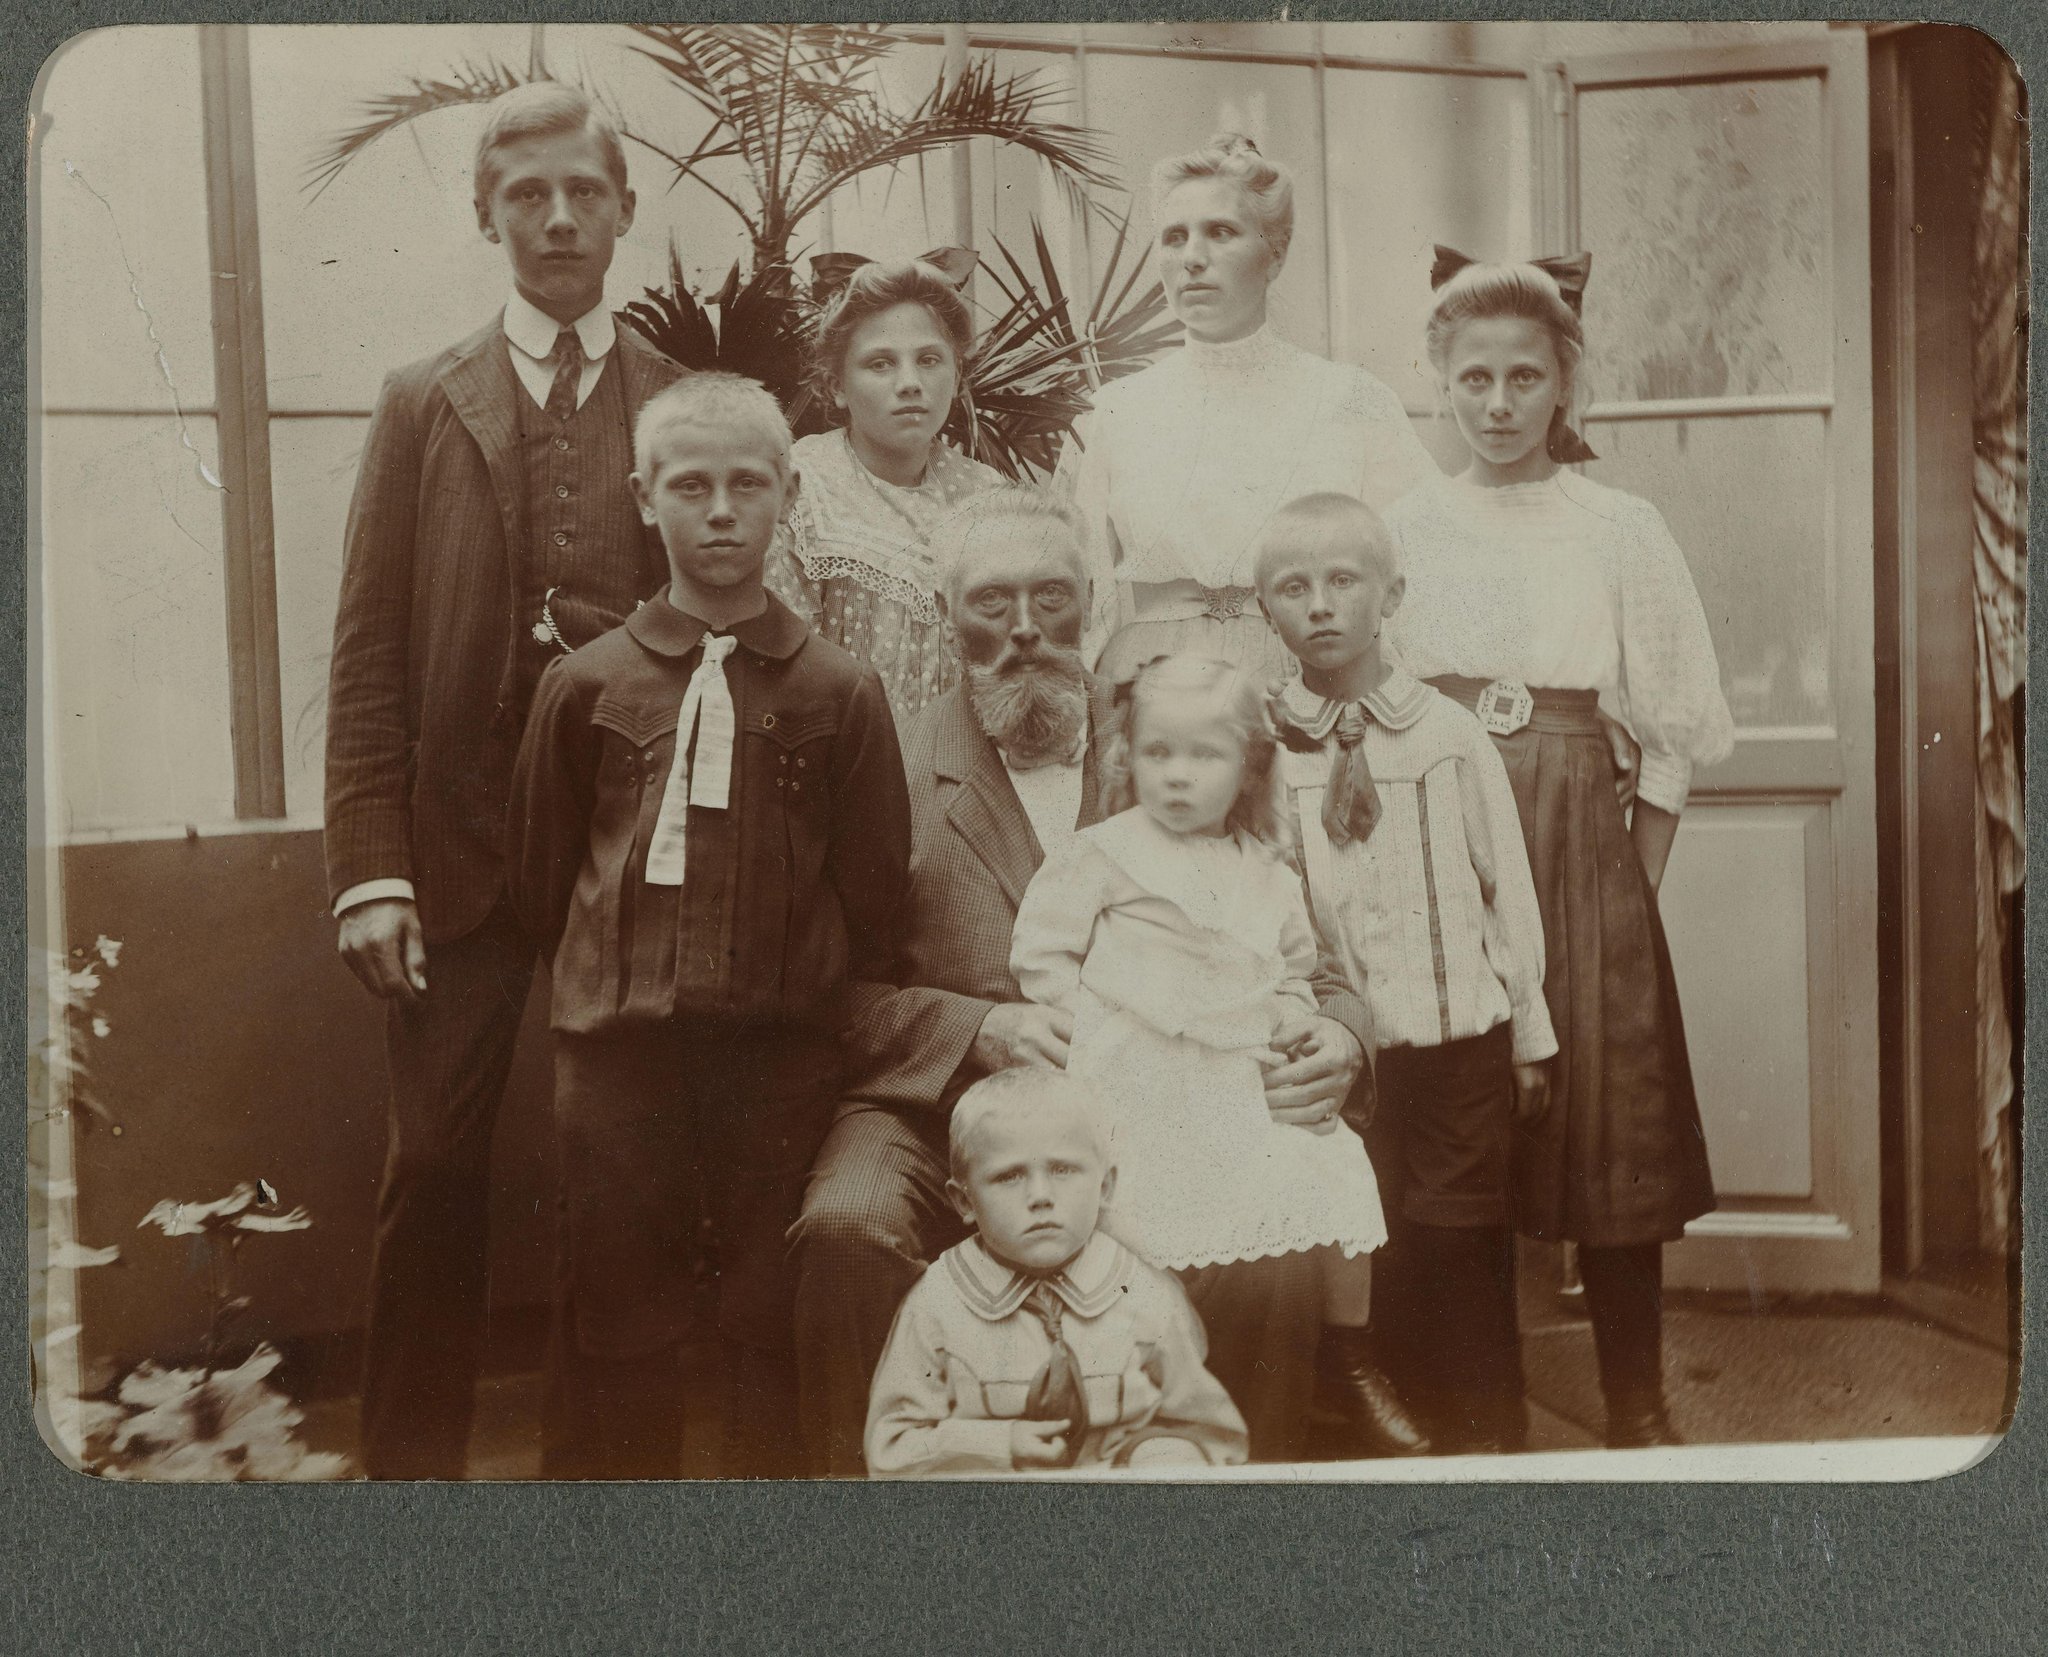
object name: photograph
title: Familieportret van kinderen in een serre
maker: christiaan otto roelofs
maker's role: fotograaf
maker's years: 1882-1970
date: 1900-1915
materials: photographic support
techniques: gelatin silver print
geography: netherlands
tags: historical persons, father and child(ren), man and child(ren) (family group)